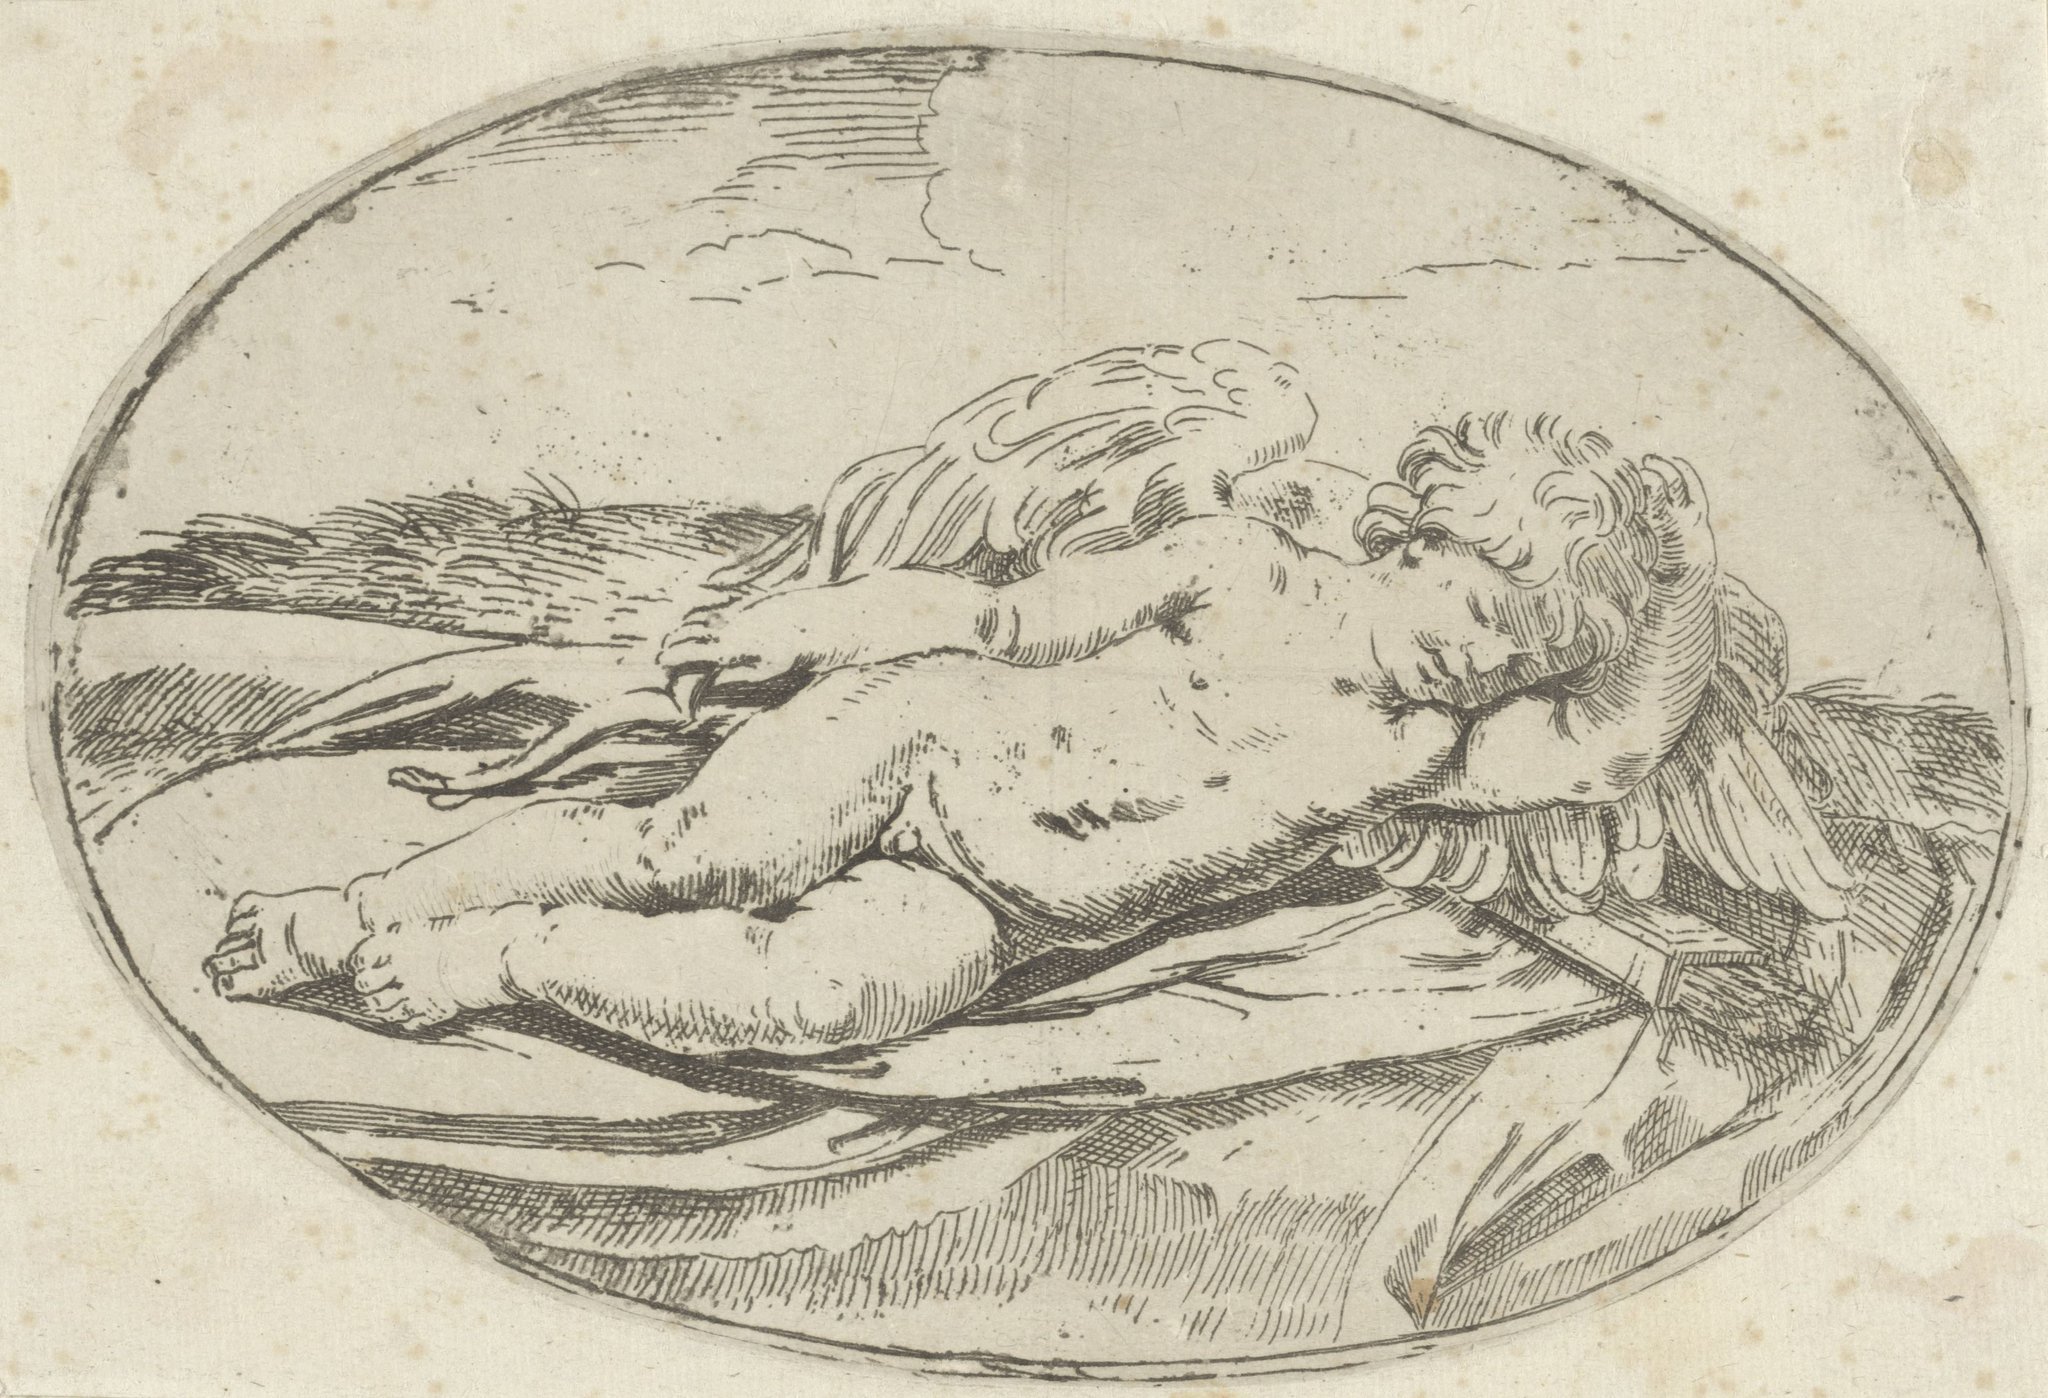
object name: print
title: Amor slapend in een landschap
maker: lorenzo loli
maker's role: print maker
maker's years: 1612-1691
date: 1622-1691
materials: paper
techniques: etching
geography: italy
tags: (story of) cupid, amor (eros), sleeping; unconsciousness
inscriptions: collector's mark: Lugt 240